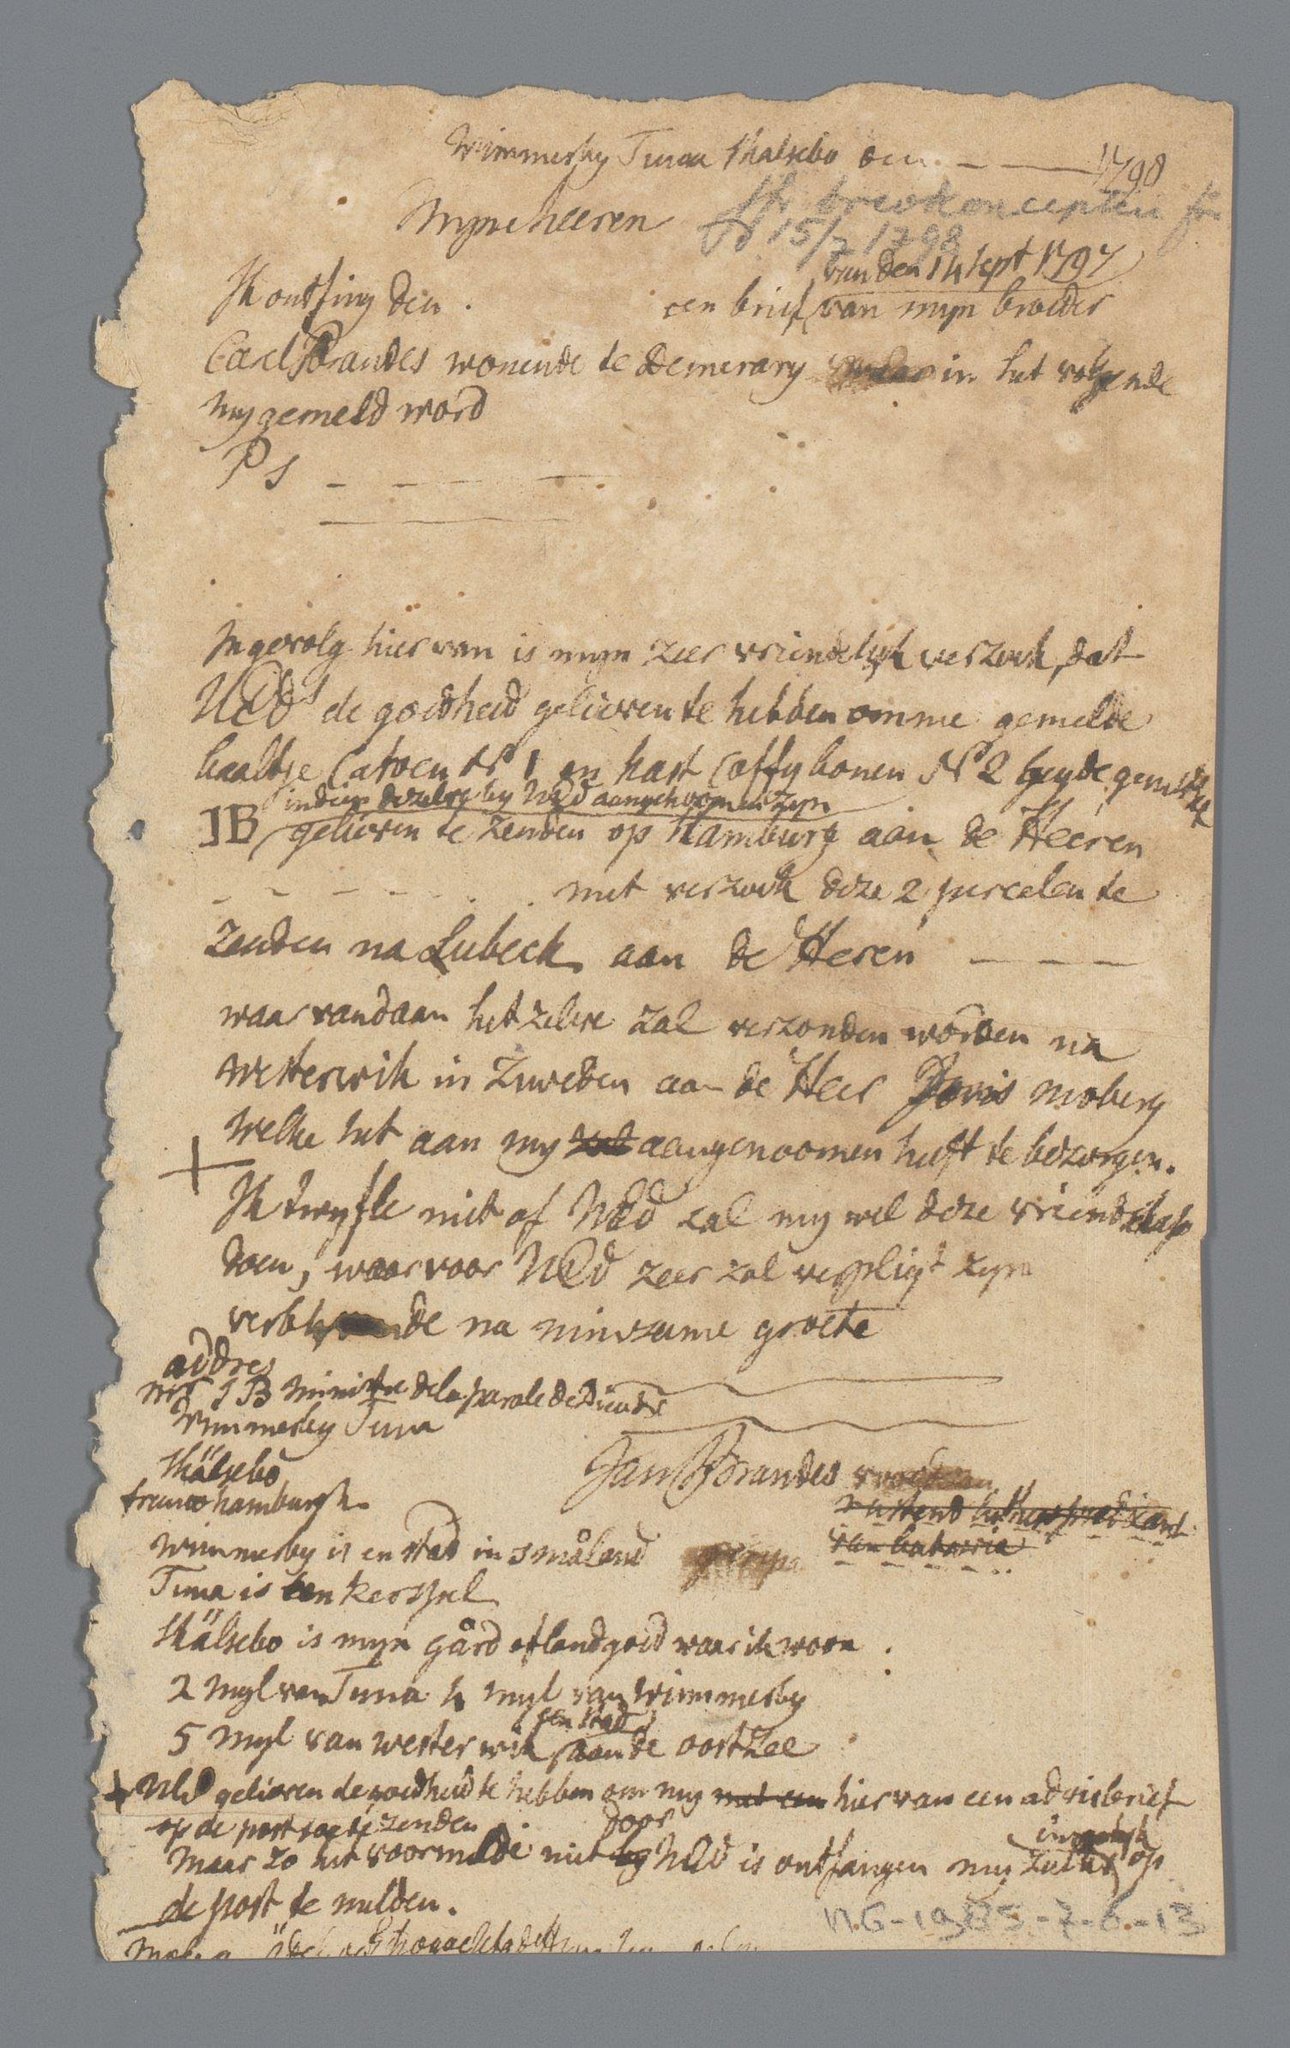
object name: book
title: Kladbrievenboek Jan Brandes (1743-1808), 1795-1800 Zweedse periode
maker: jan brandes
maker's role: draughtsman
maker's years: 1743-1808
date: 1795-1800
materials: paper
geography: skälsebo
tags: bodegraven, draughtsman, jan brandes